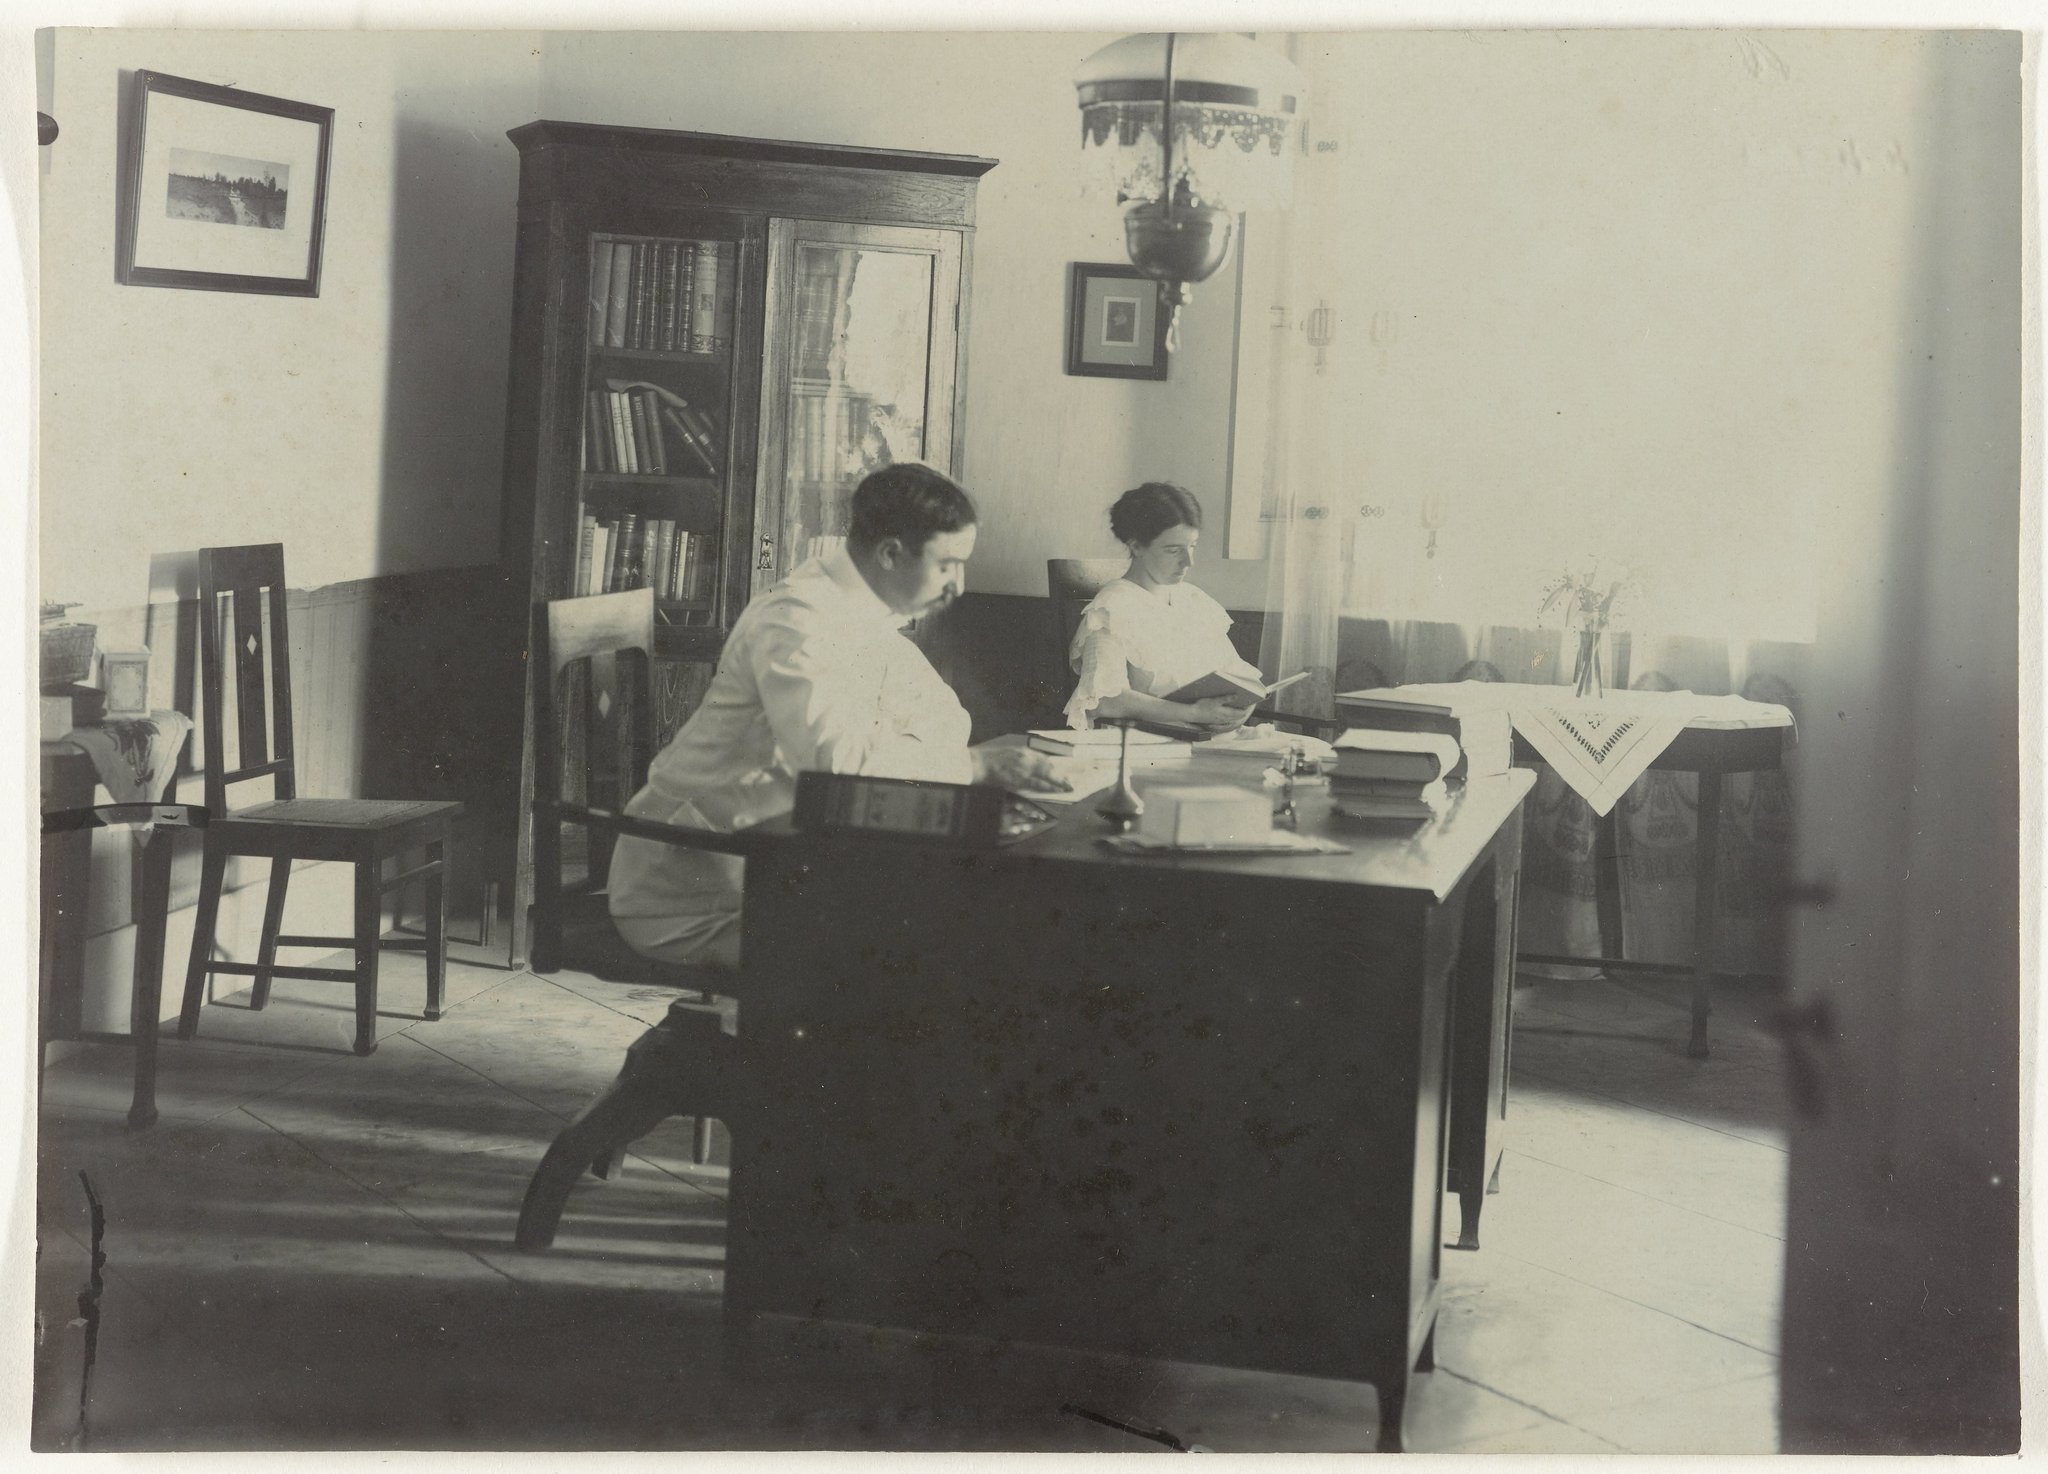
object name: photograph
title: Het echtpaar Letterie in hun werkkamer in hun huis te Mojosari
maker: Anonymous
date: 1913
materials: photographic support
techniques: photography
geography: mojosari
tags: communal rooms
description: Het echtpaar Letterie in hun werkkamer in hun huis te Mojosari aan het werk.